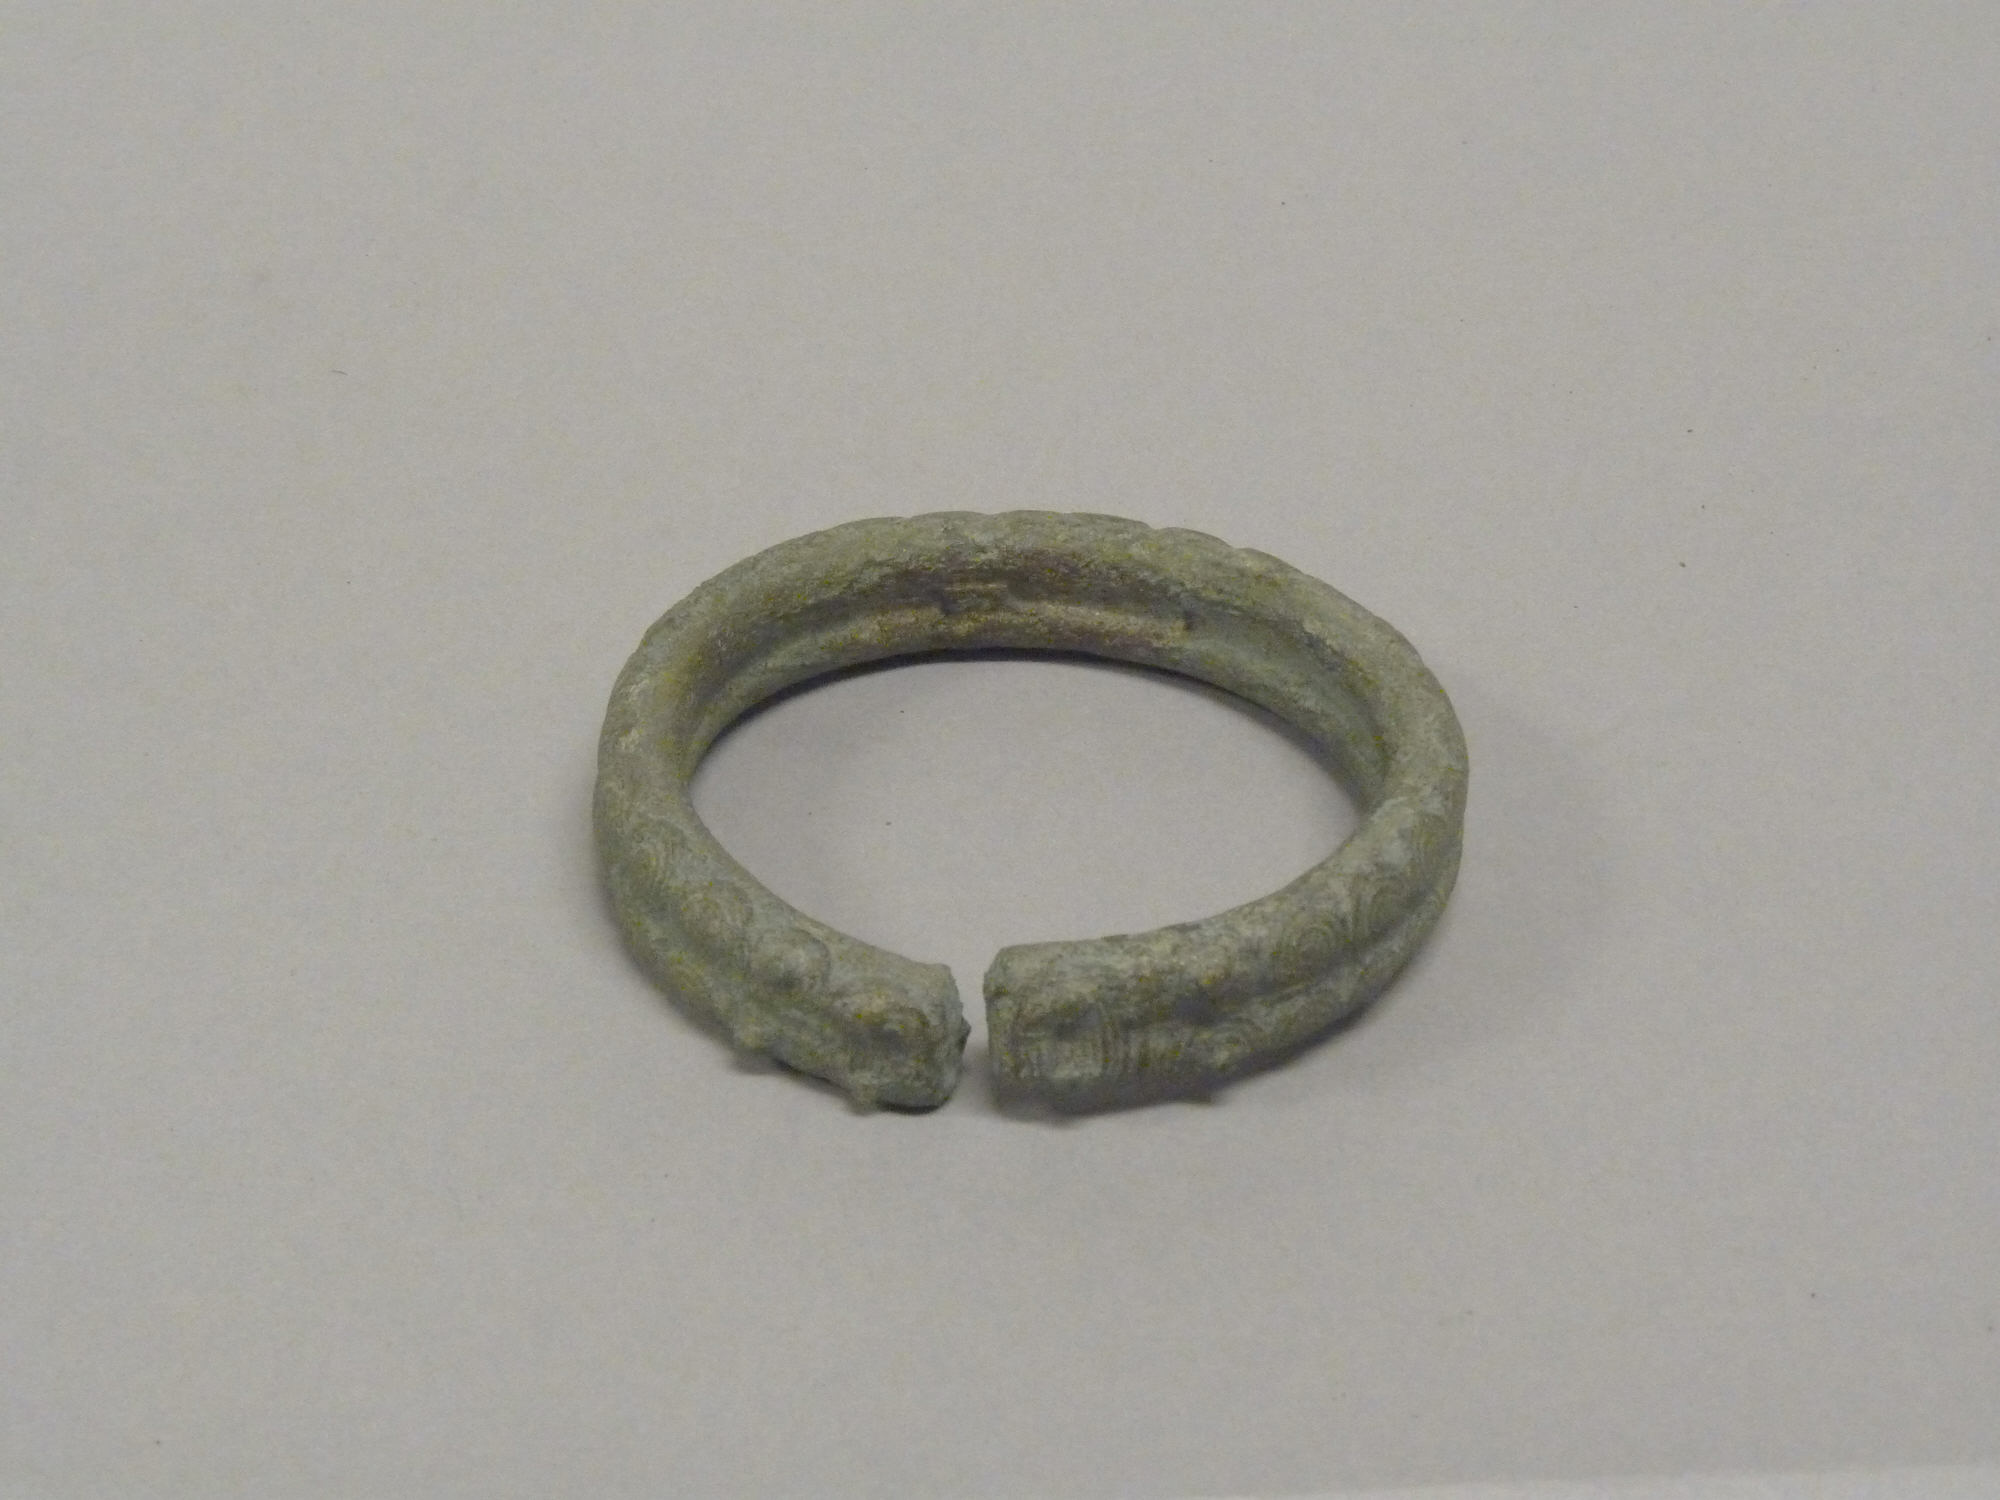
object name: one of a pair of bangle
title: One from a Pair of Solid Open Bangles with Two Rows of Concentric Circles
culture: thai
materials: bronze